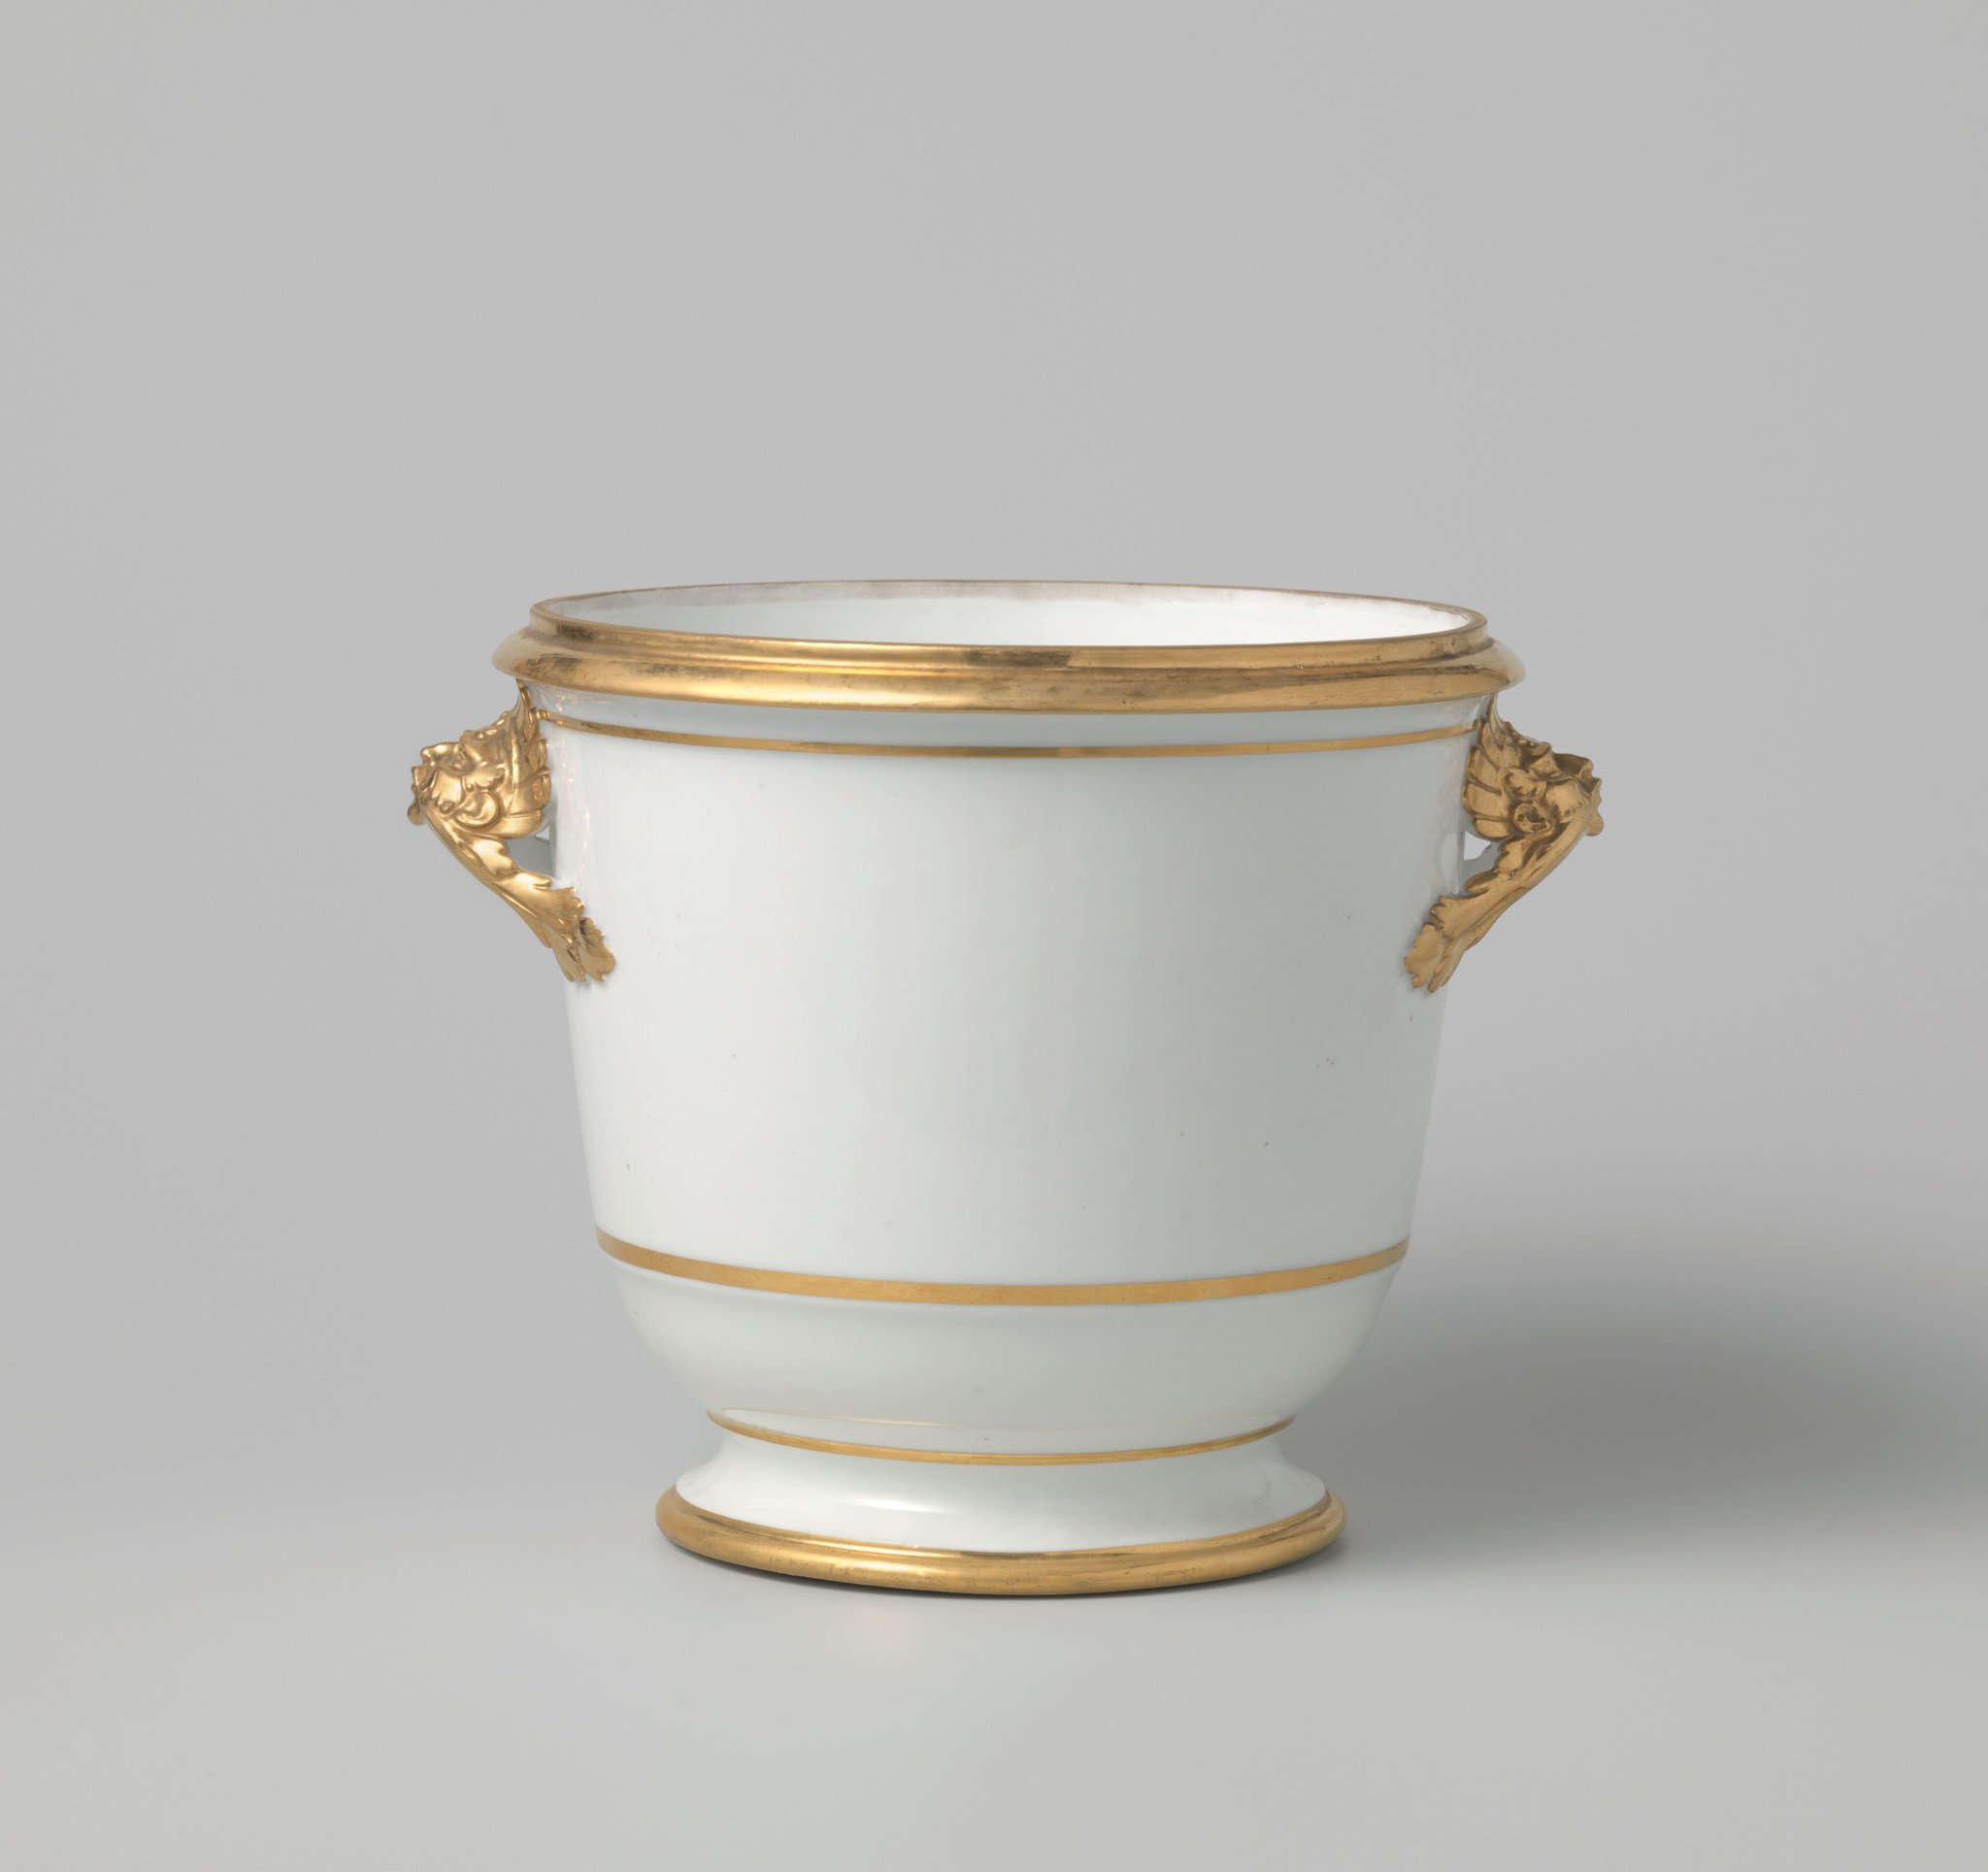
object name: cachepot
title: Cachepot or flowerpot with mask-shaped handles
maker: Anonymous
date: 1800-1824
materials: glaze, gold, paint, porcelain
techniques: firing, forming, gilding, turning, vitrification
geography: france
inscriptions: mark: ‘twee gekruiste zwaarden’, mark: ‘BX’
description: Chachepot of bloempot van porselein, beschilderd op het glazuur in goud. De pot heeft een cilindrisch, naar boven iets uitlopende buik, die rond afloopt naar de spreidende voet. Profiel onder de rechte rand. De twee oren zijn gemodelleerd in de vorm van maskers. Gemerkt op de onderzijde met twee gekruiste zwaarden van de Meissen porseleinfabriek en BX.